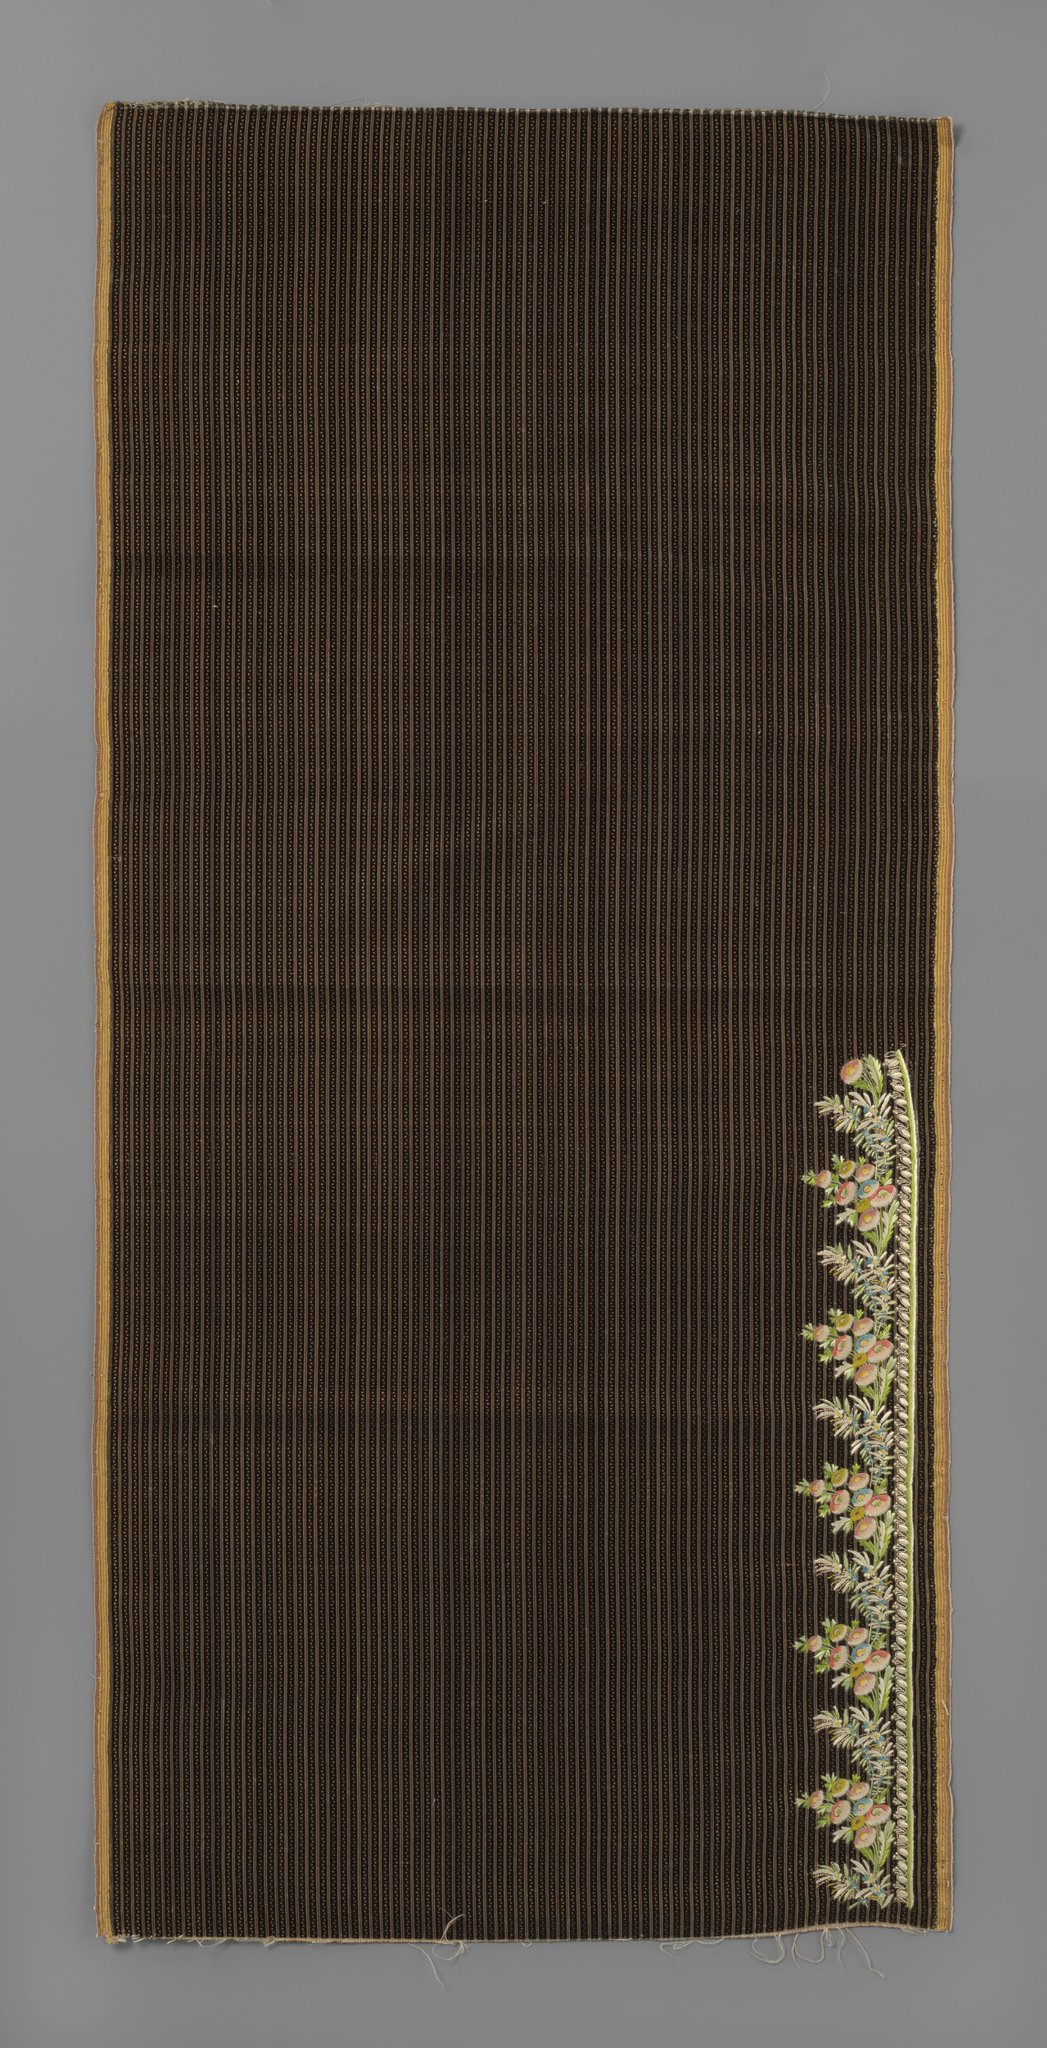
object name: frak, frac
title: Paneel behorende bij een ongesneden frak van zijdenvelours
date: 1780-1790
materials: silk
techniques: embroidered, weave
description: In de 18e eeuw werden kledingstukken à disposition geborduurd. Dit betekent dat de contour van het kledingstuk met alle daarbij behorende versieringen door de borduurwerker werden geborduurd en pas daarna werden de panden of panneaux naar de kleermaker gebracht voor verdere verwerkingen. De knopen b.v. werden door de kleermaker uitgeknipt en rondom een kern van hout of ander stevig materiaal gewerkt.